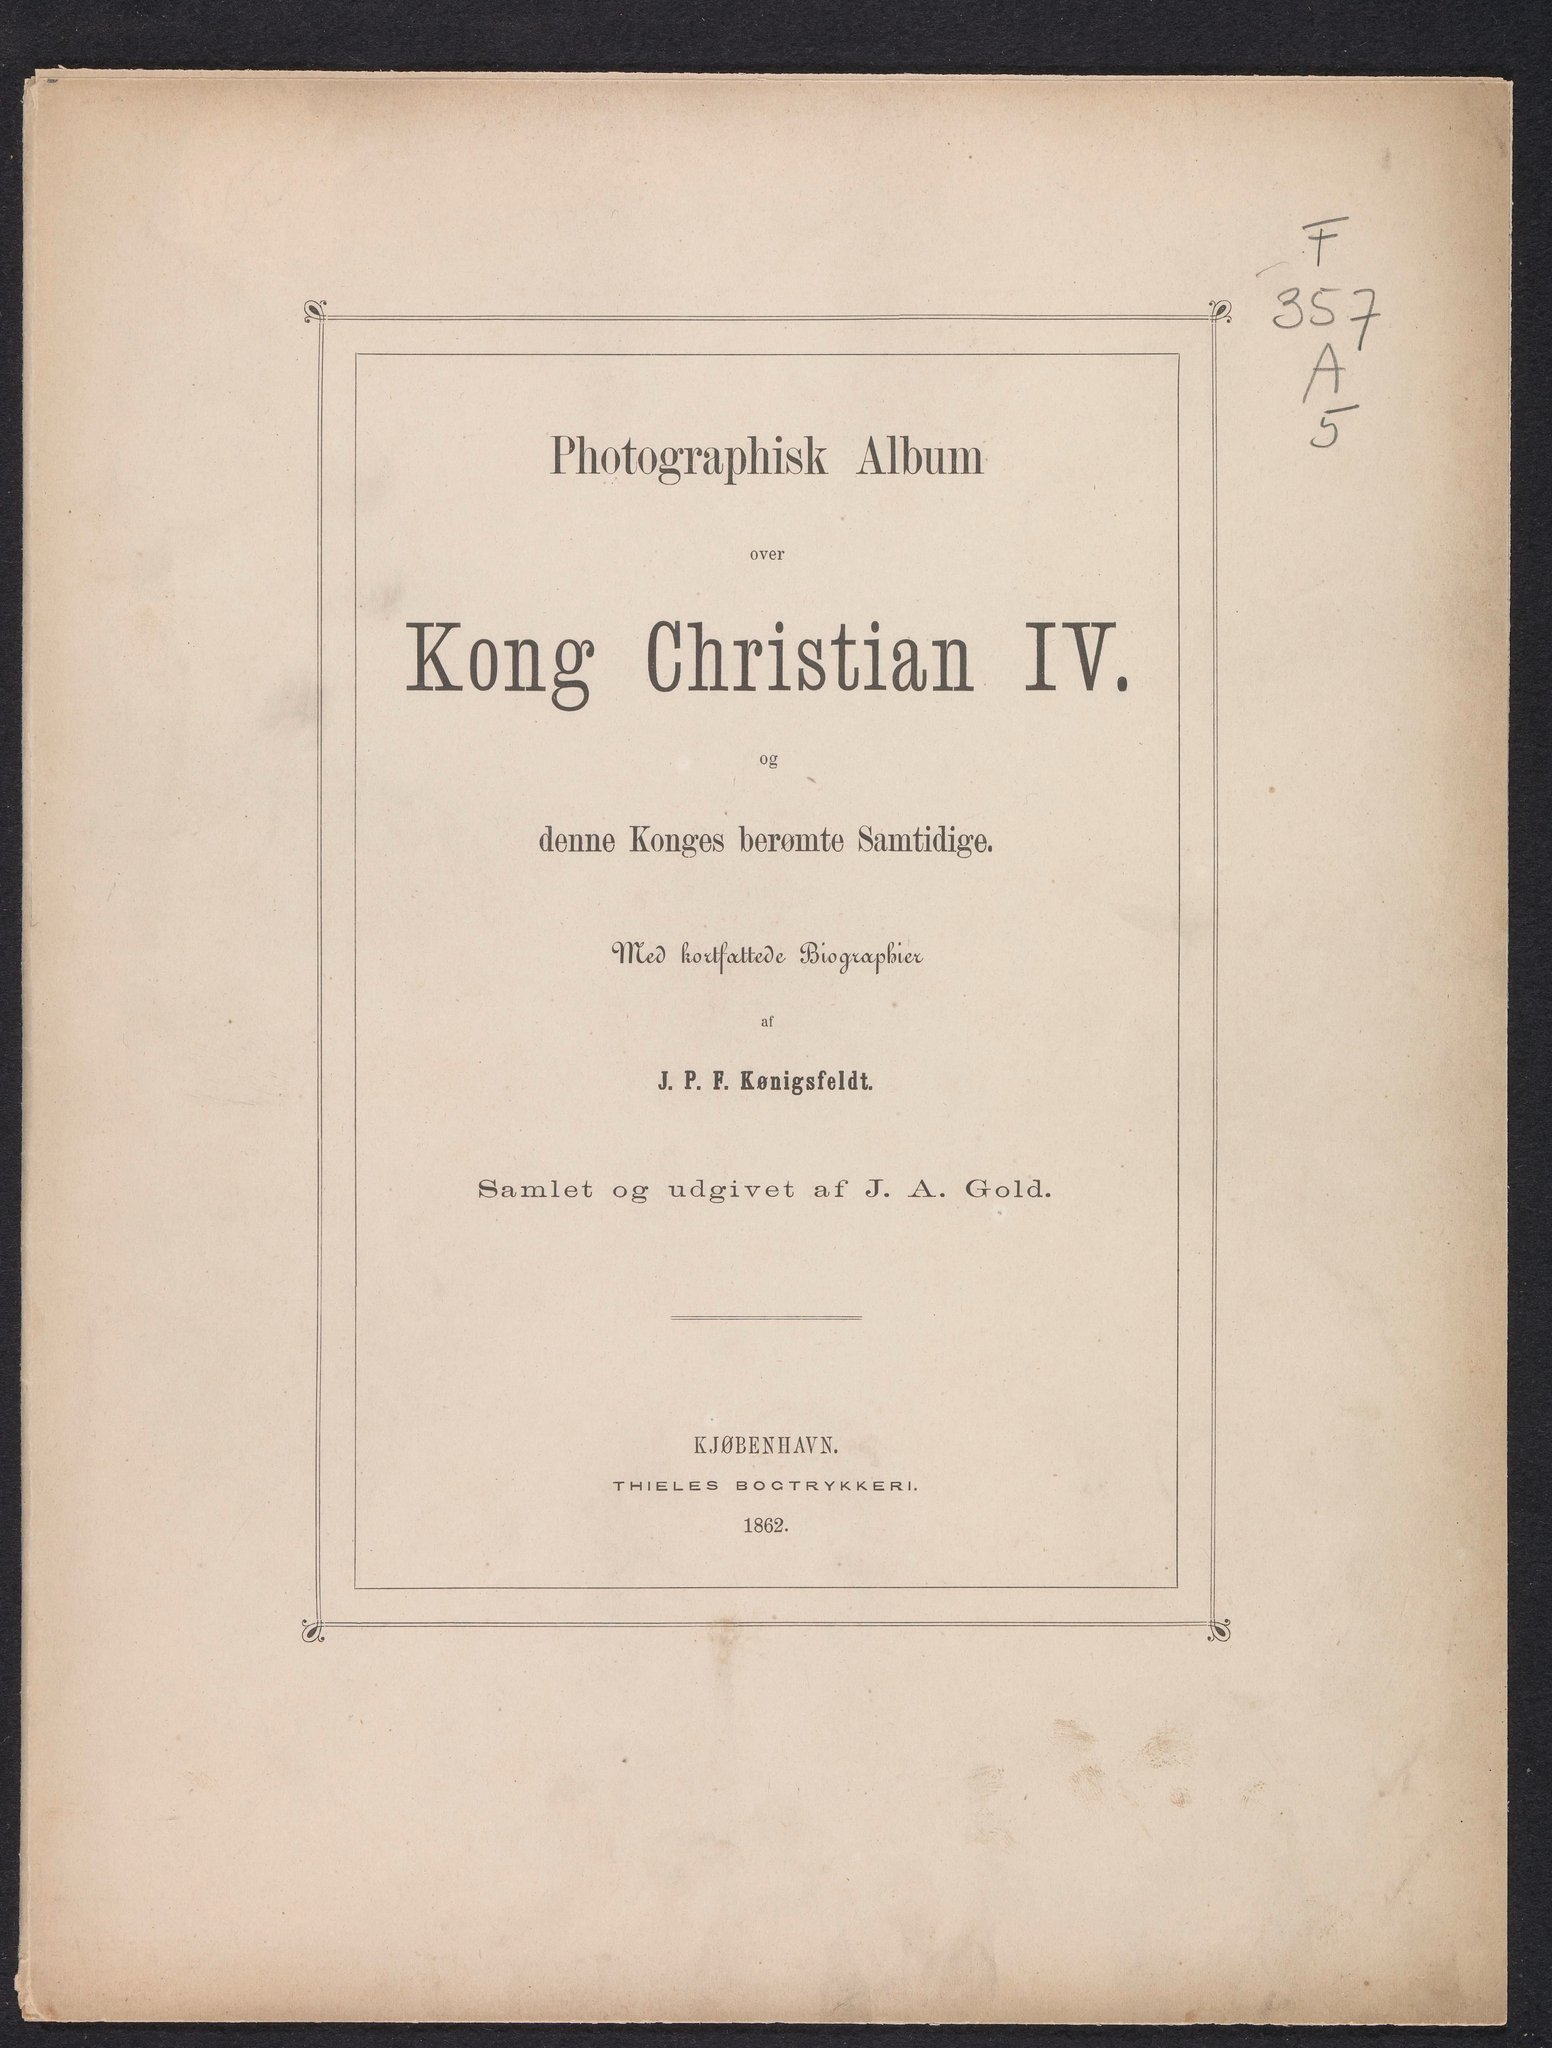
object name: book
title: Photographisk album over Kong Christian IV og denne konges beroemte samtidige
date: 1862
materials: cardboard, leather, paper, photographic support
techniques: albumen print, printing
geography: copenhagen